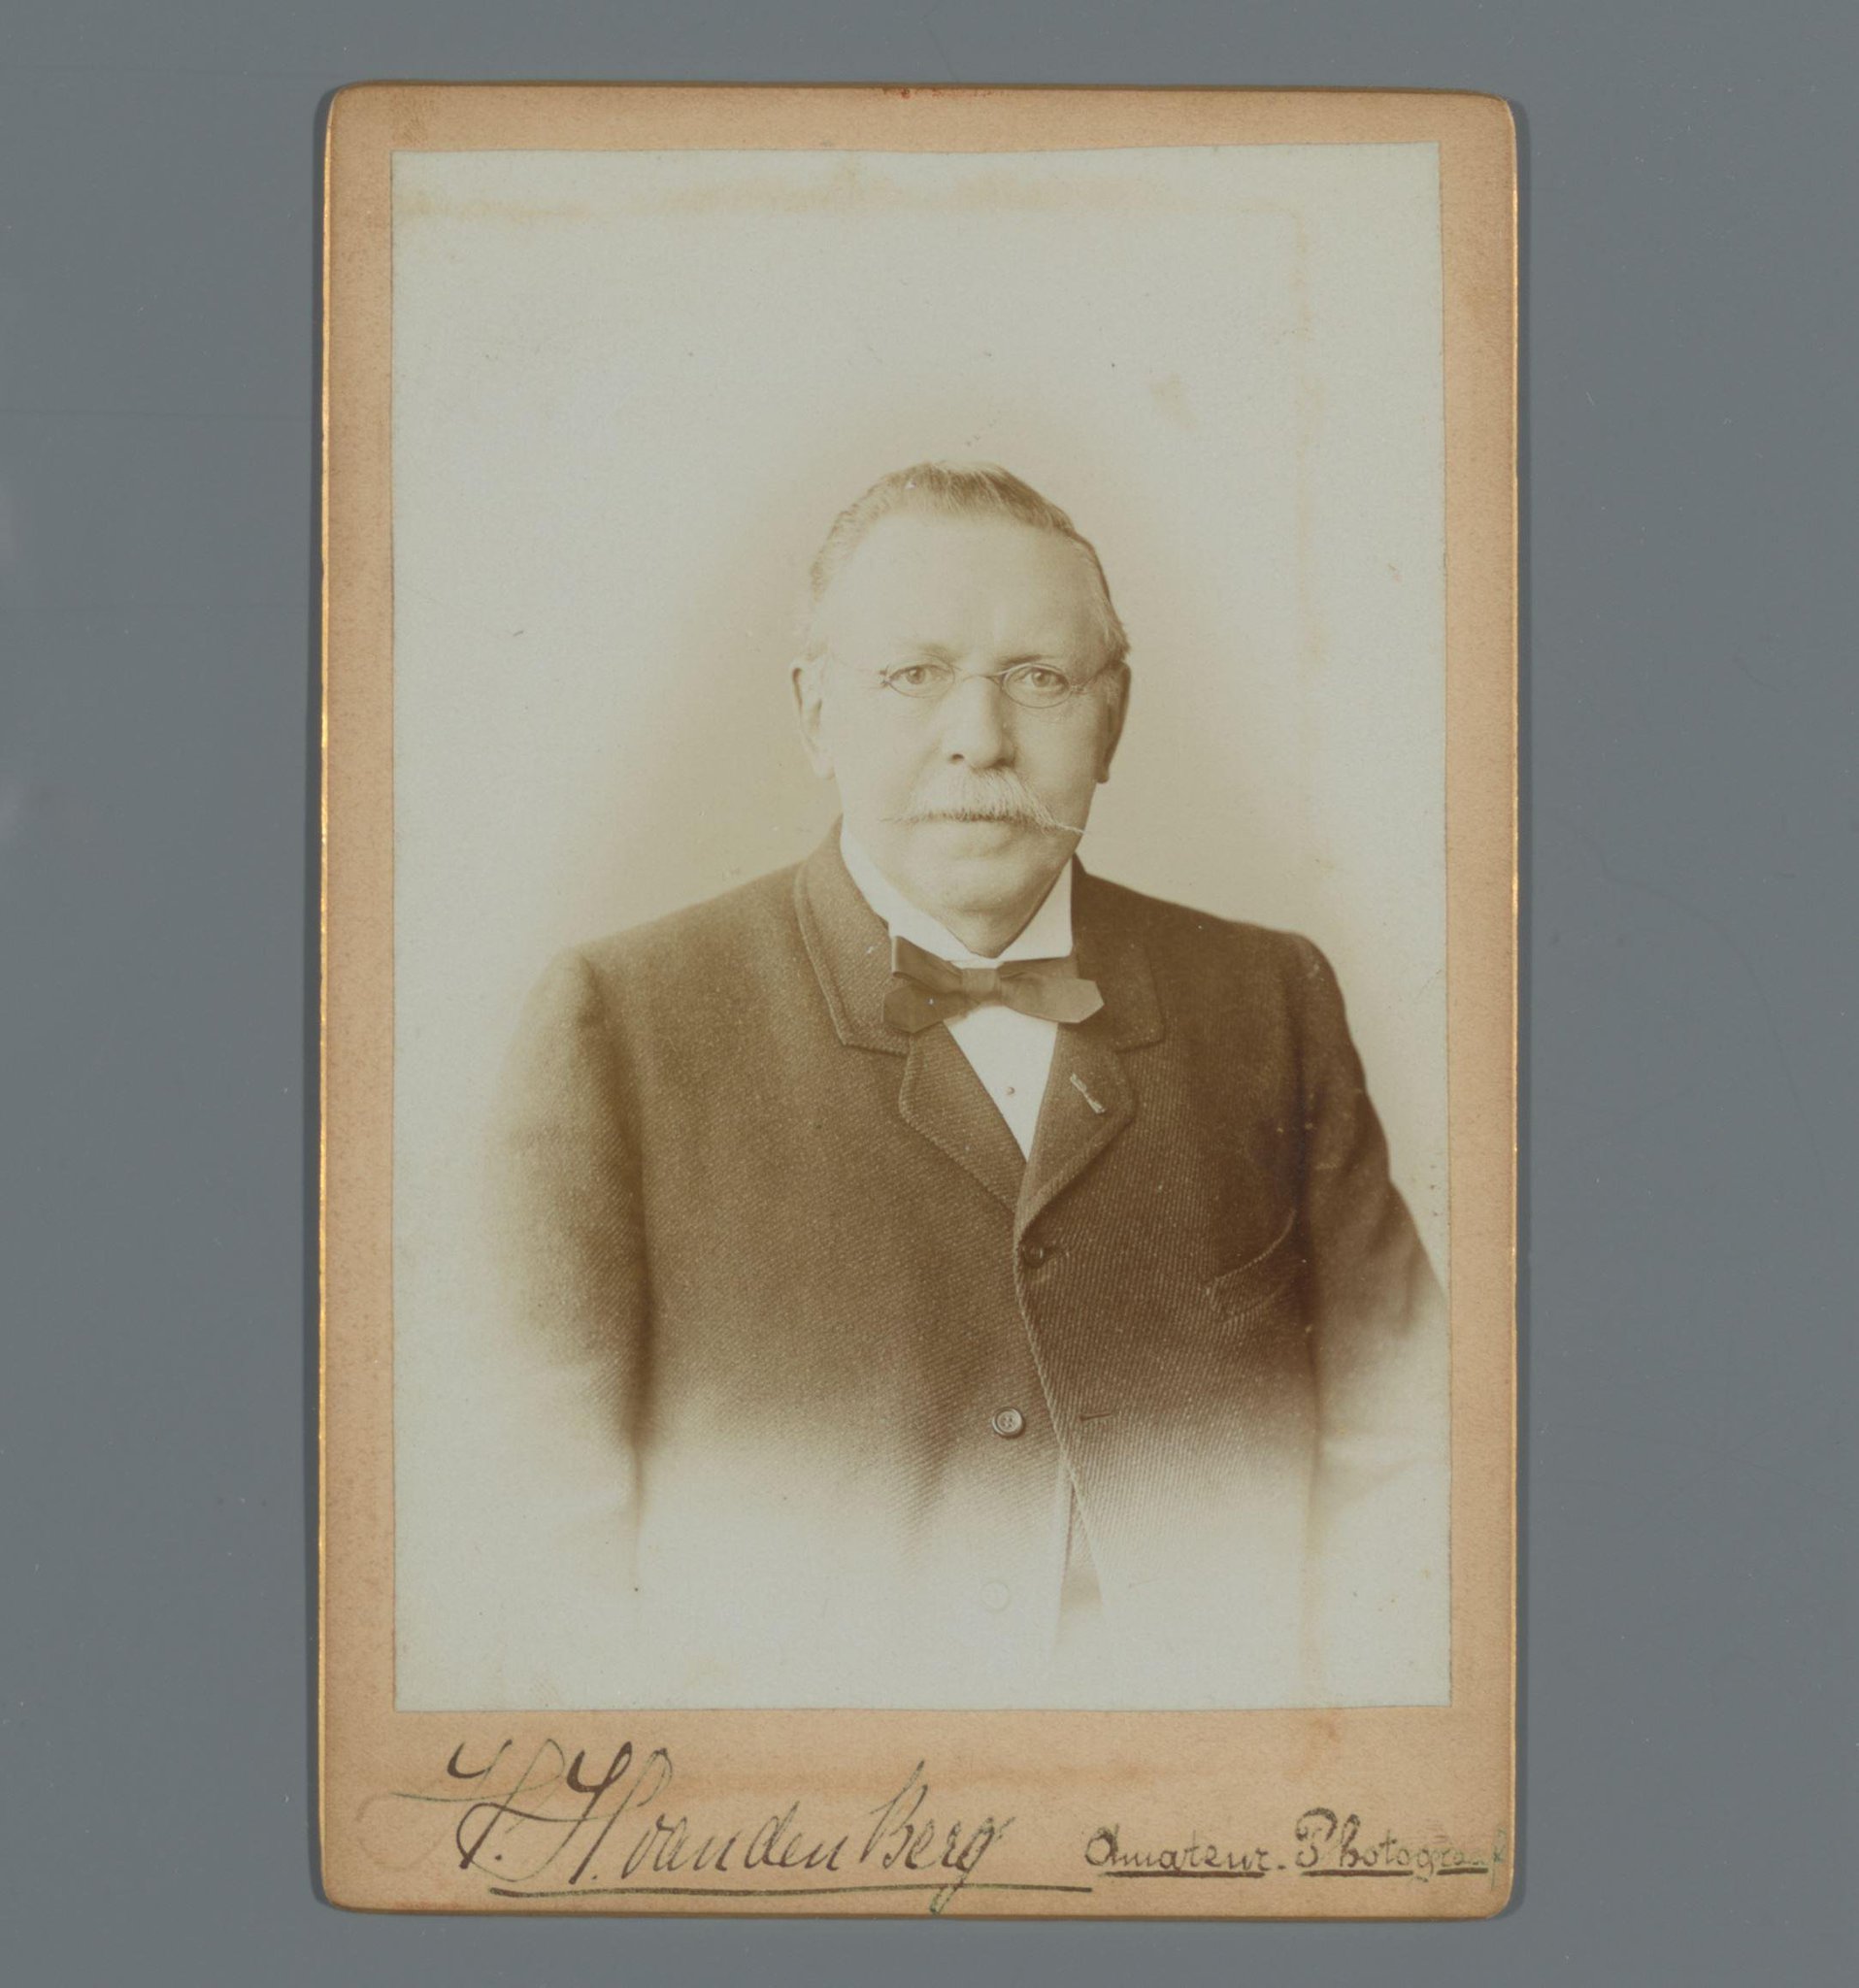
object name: photograph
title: Portret van Mr Nobert Petrus van den Berg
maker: hendrik herman van den berg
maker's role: amateurfotograaf, jurist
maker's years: 1875-1944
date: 1890-1896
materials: cardboard, photographic support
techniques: gelatin silver print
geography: amsterdam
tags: rotterdam, norbertus petrus van den berg (1831-1917), historical persons (portraits and scenes from the life)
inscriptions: signature: ‘H.H. van den Berg Amateur-Photograaf’